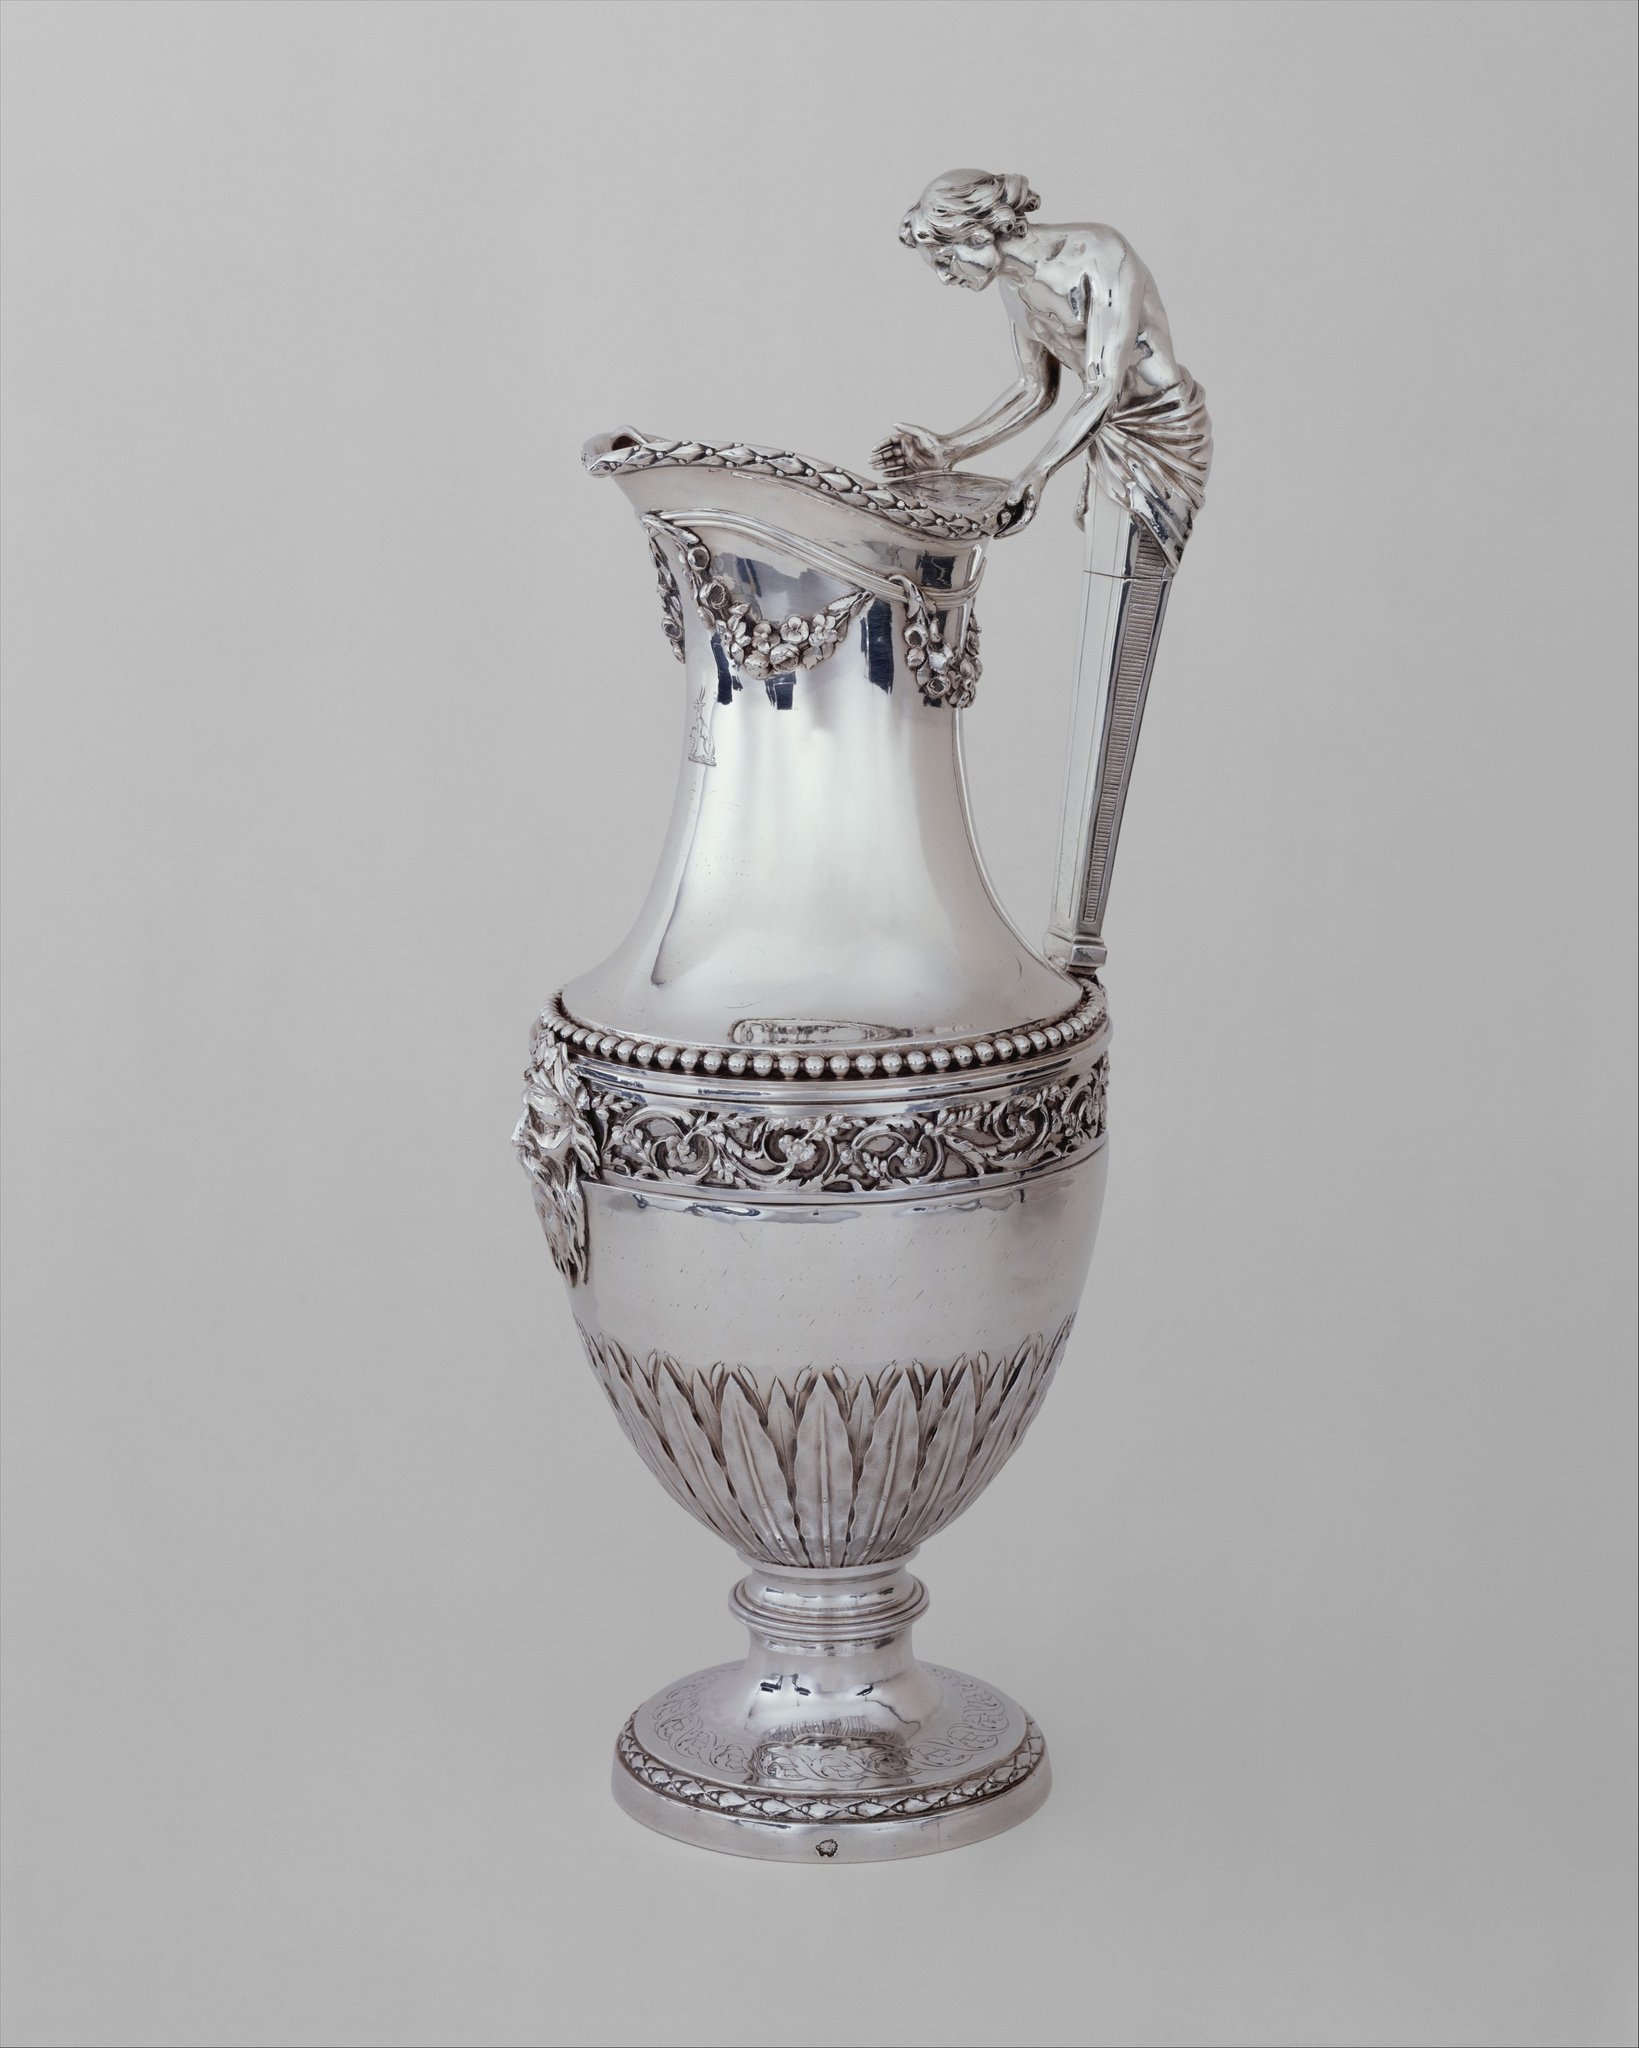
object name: ewer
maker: jean-baptiste-françois chéret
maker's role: maker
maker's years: 1728-1791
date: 1784-1785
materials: silver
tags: men,narcissus